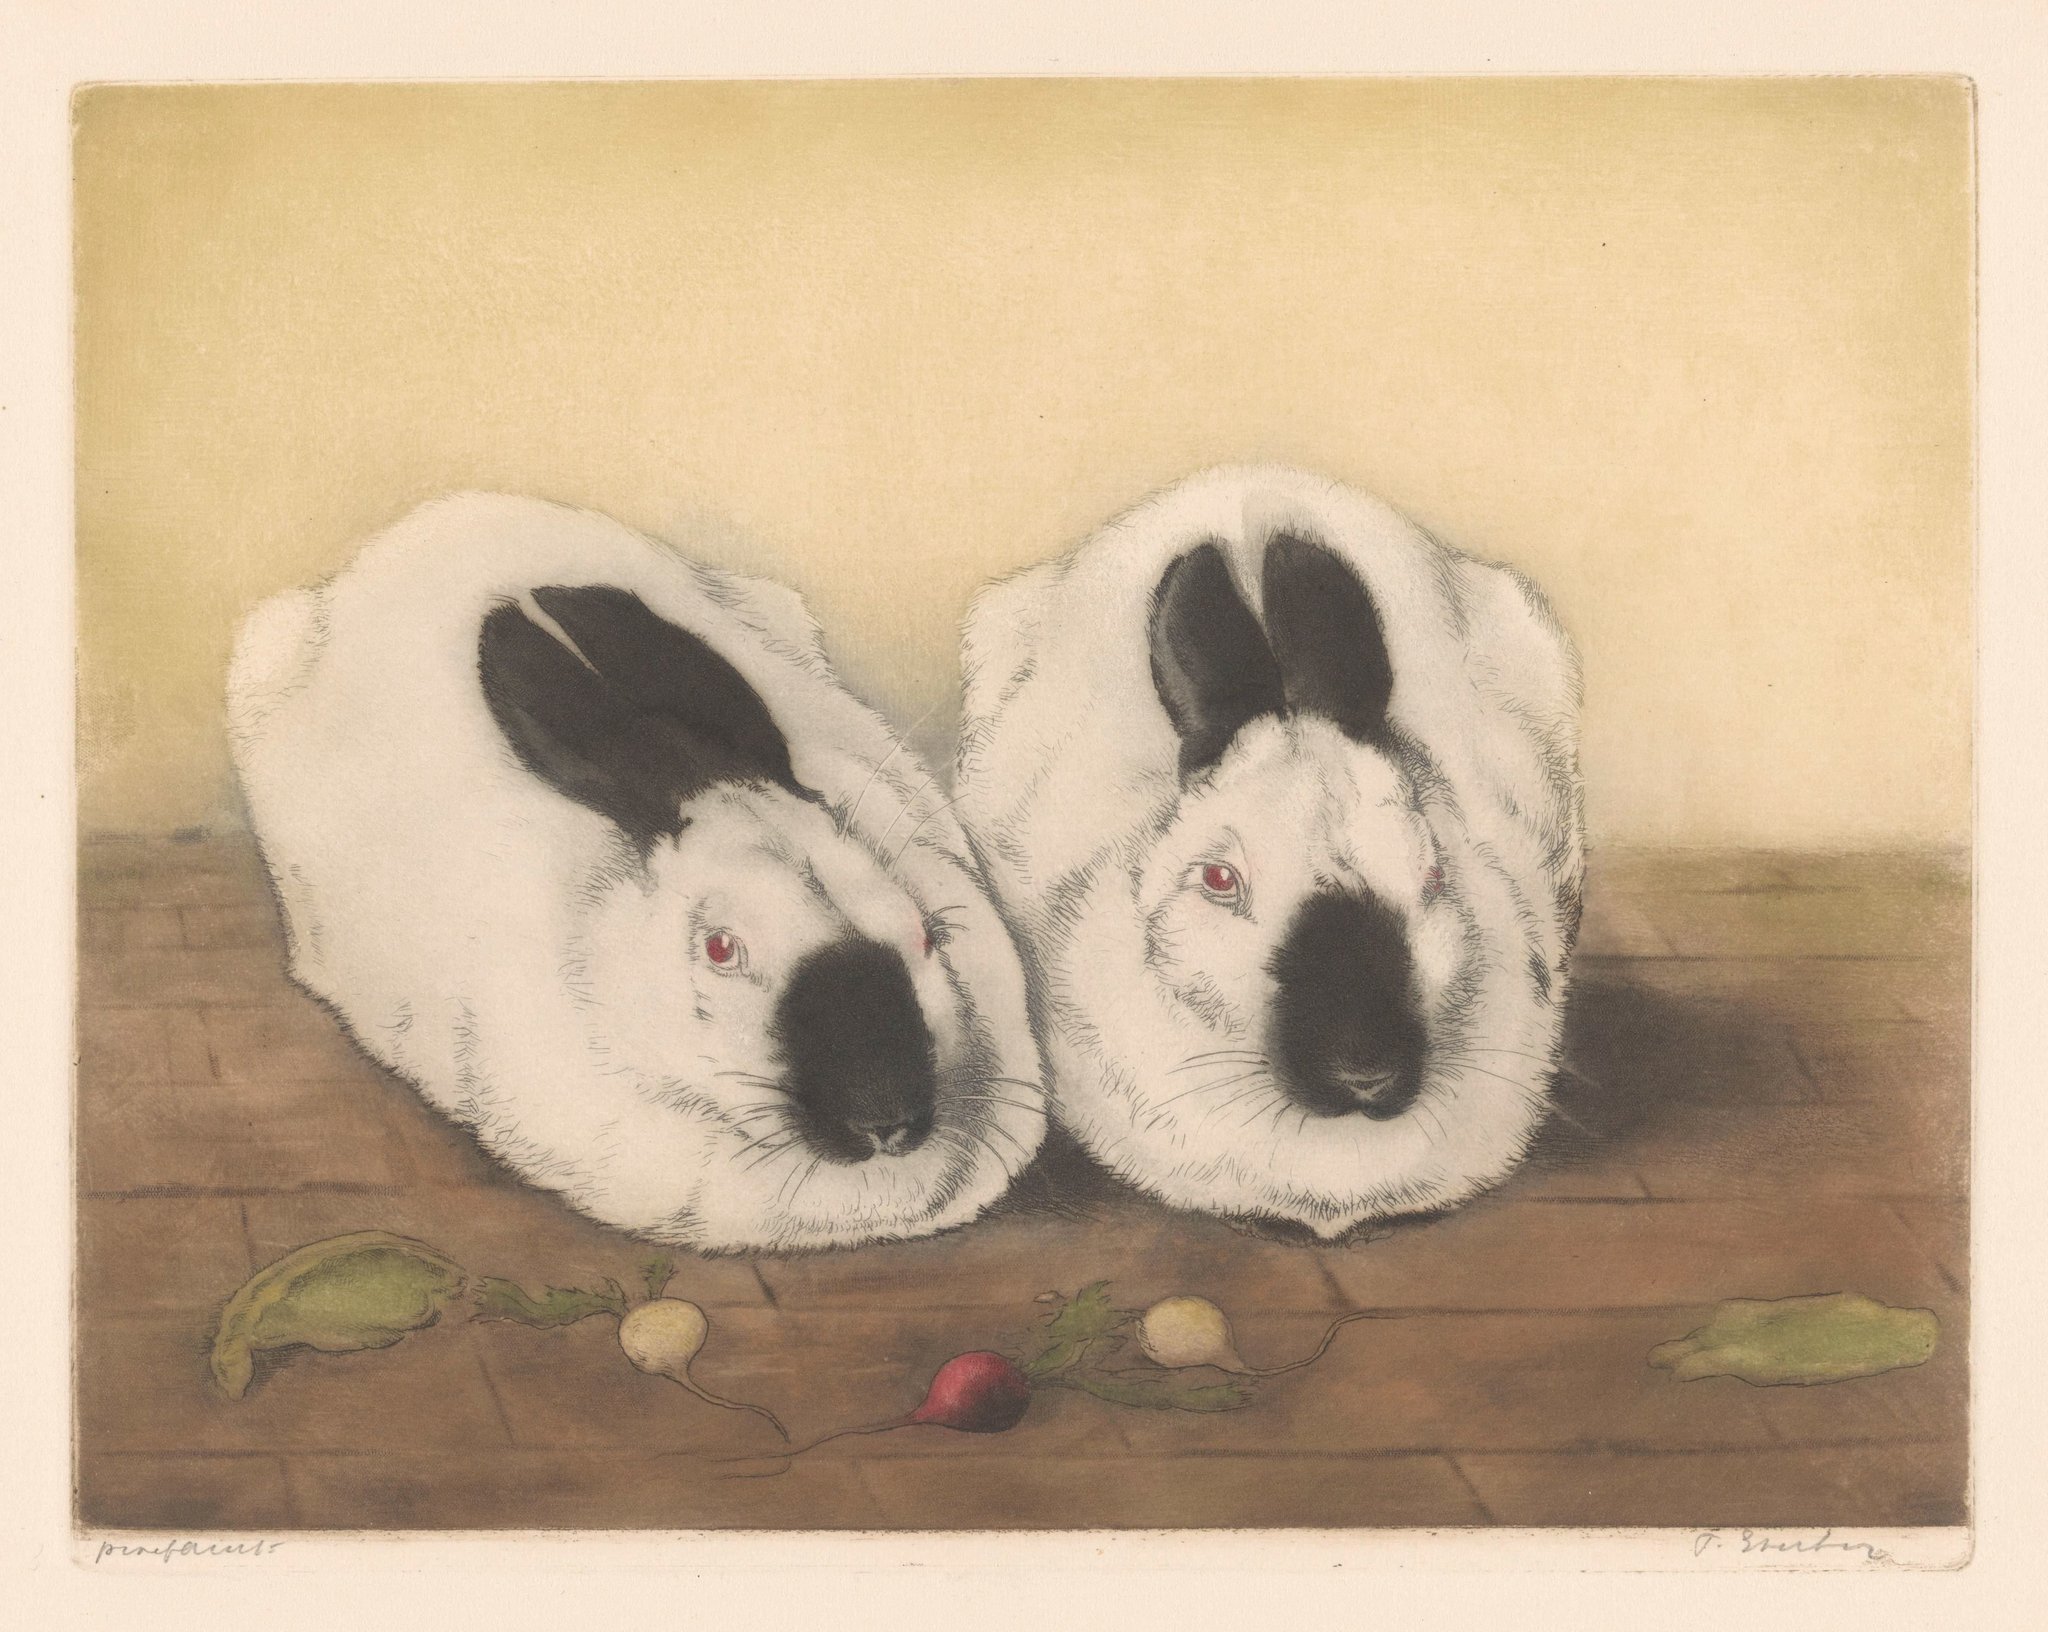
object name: print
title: Two Himalayan Rabbits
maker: frans everbag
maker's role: draughtsman, print maker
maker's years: 1877-1947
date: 1887-1931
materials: paper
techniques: aquatint, etching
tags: rodents: rabbit, (non-fruit) products of plants or trees: radish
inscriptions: collector's mark: Lugt 2228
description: Twee liggende konijnen, zogenaamde Brandneuzen, ook wel Russen genoemd. Voor hen ligt witte en rode radijs.